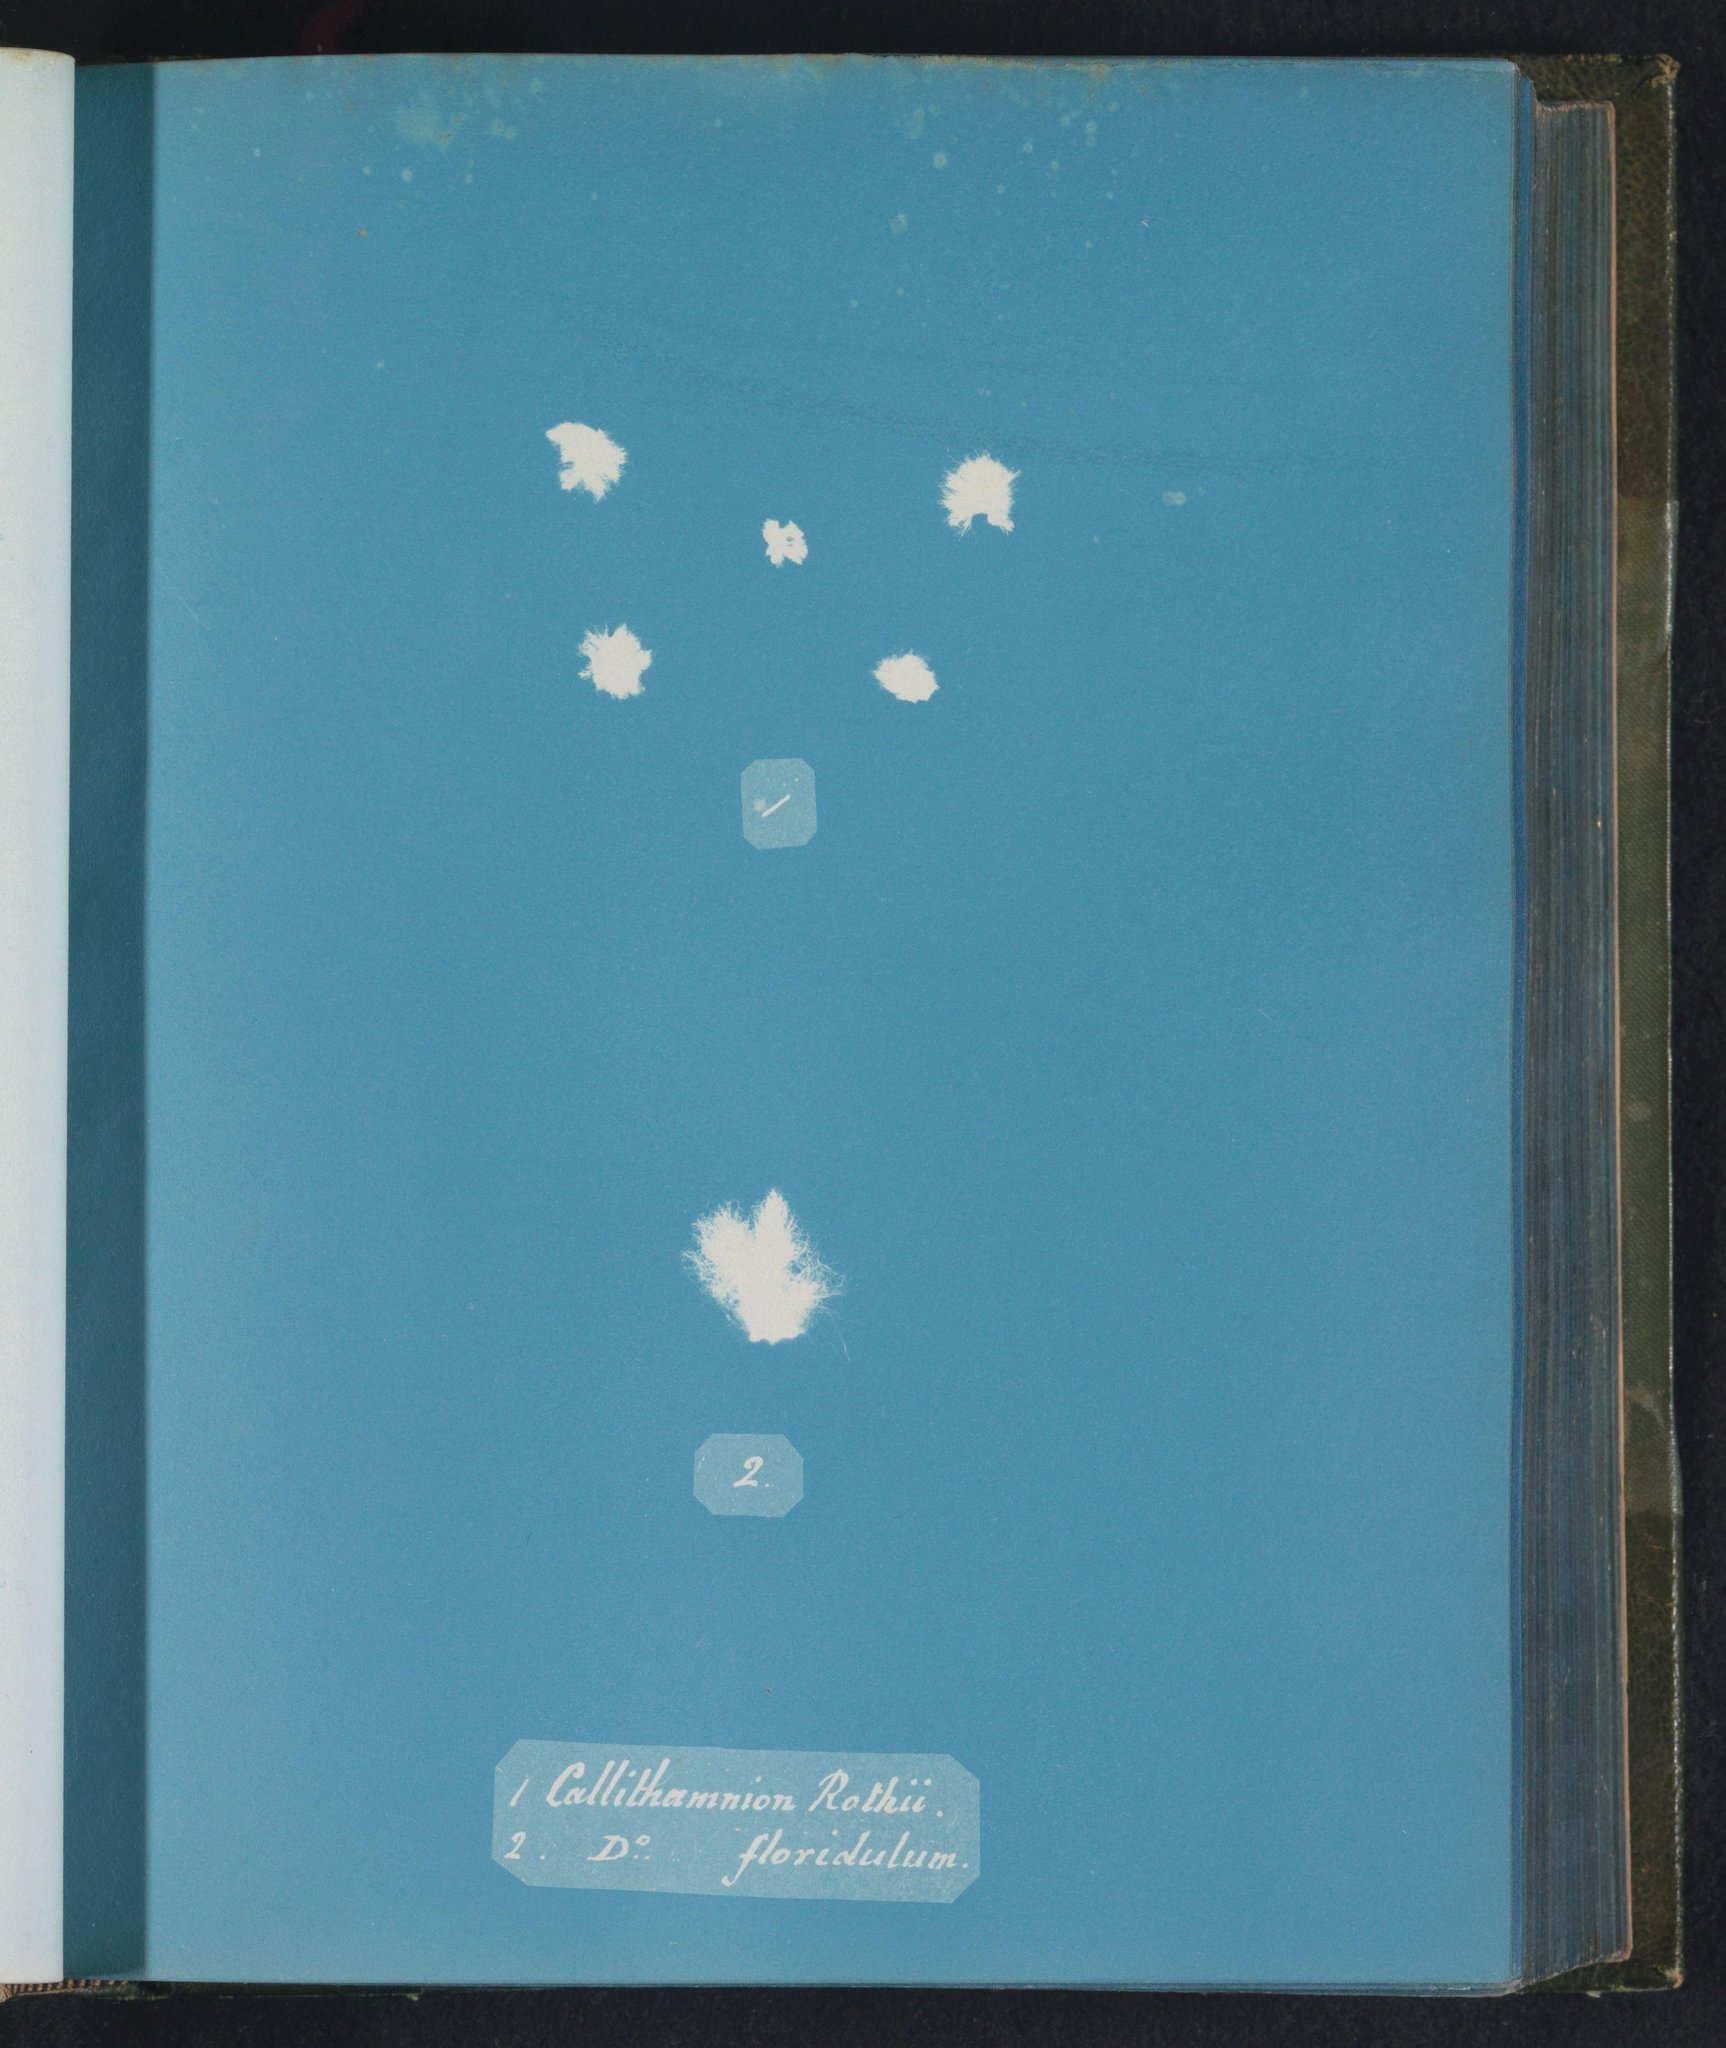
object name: photograph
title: Callithamnion rothii [&] D[itt]o floridulum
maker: anna atkins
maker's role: fotograaf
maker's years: 1799-1871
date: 1843-1853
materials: photographic support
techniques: cyanotype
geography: united kingdom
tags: algae, seaweed